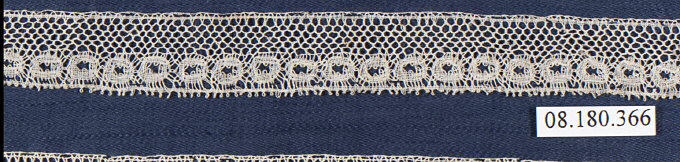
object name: piece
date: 1701-1800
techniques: lace